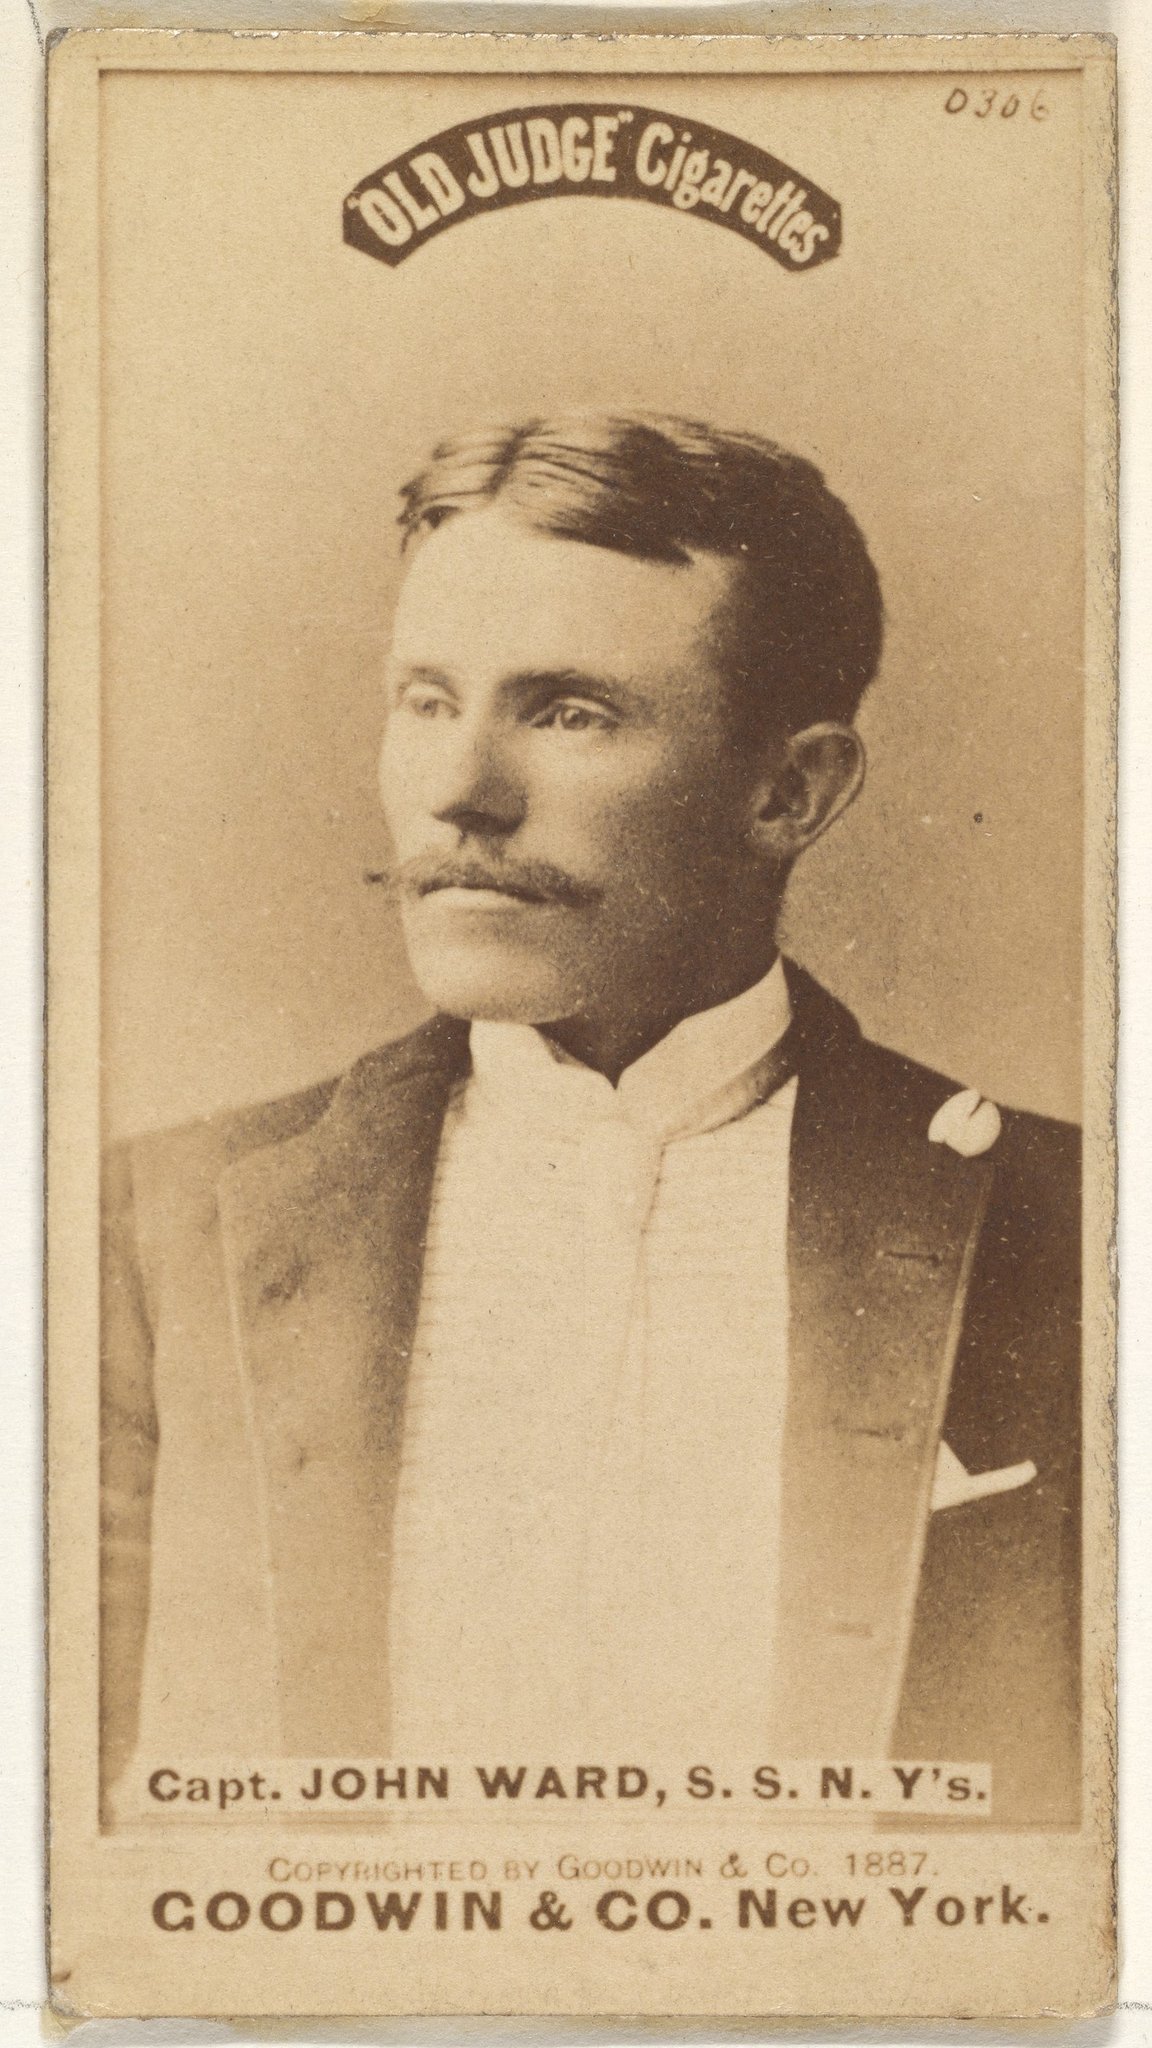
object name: baseball card, photograph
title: John Montgomery Ward, Captain and Shortstop, New York, from the Old Judge series (N172) for Old Judge Cigarettes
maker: goodwin & company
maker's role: publisher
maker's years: 1850-1950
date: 1887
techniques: albumen silver print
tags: men,portraits,baseball,athletes